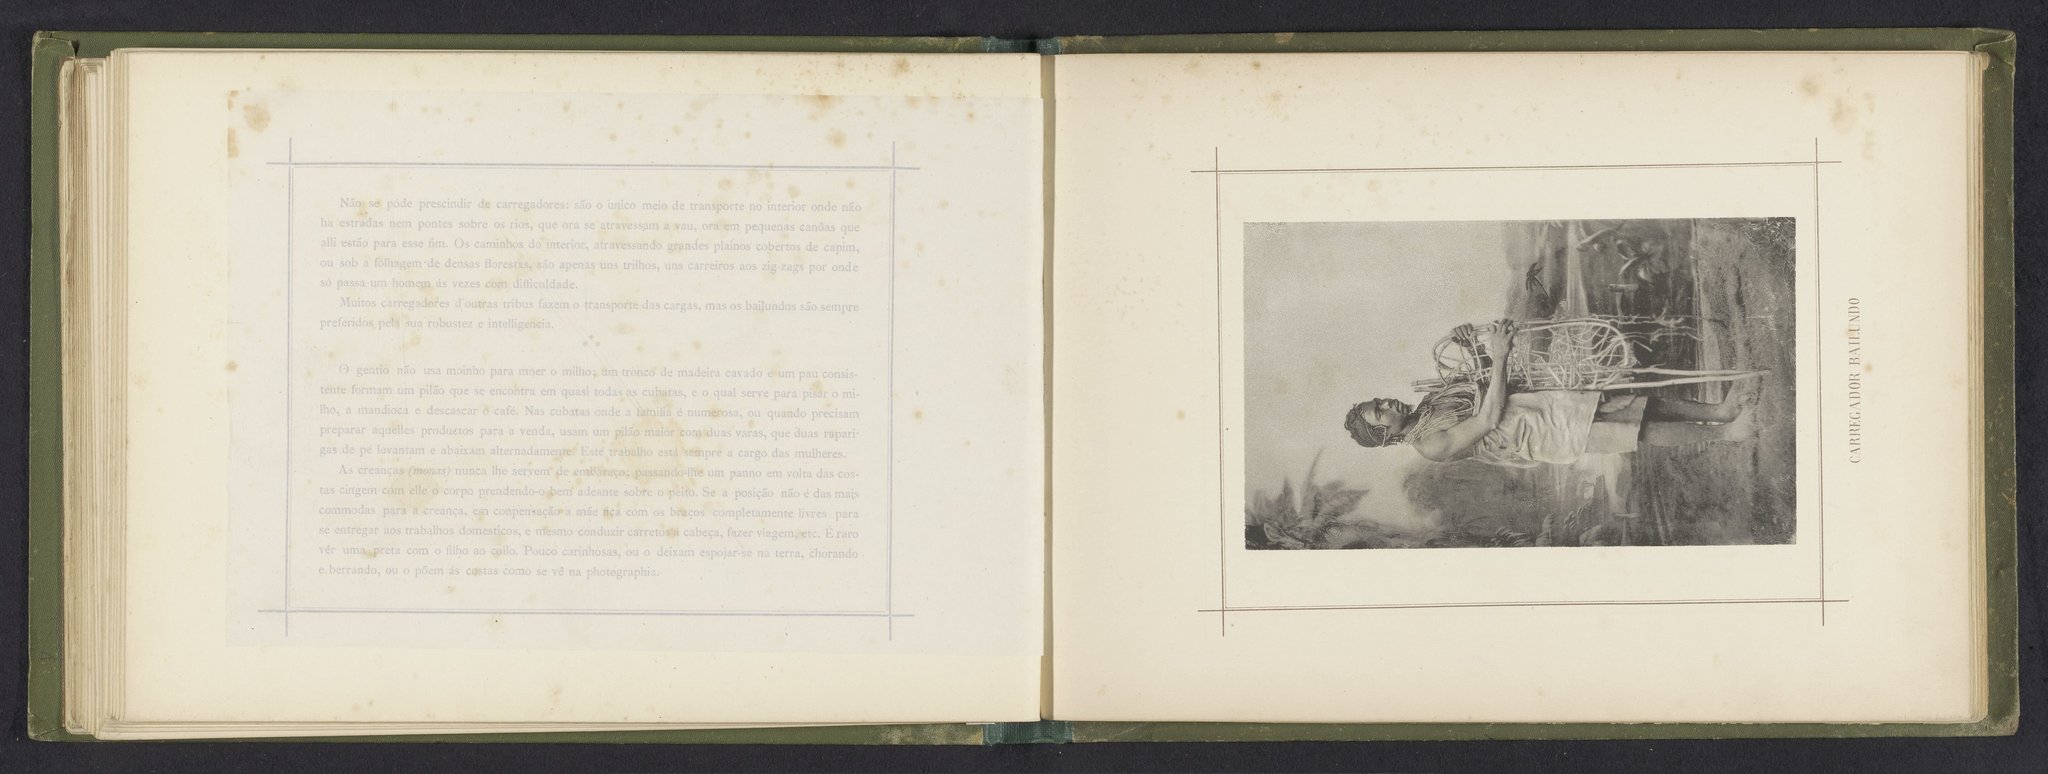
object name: photomechanical print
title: Kruier uit Bailundo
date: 1876-1886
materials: paper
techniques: photograph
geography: angola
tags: anonymous historical person portrayed alone, porter, bearer